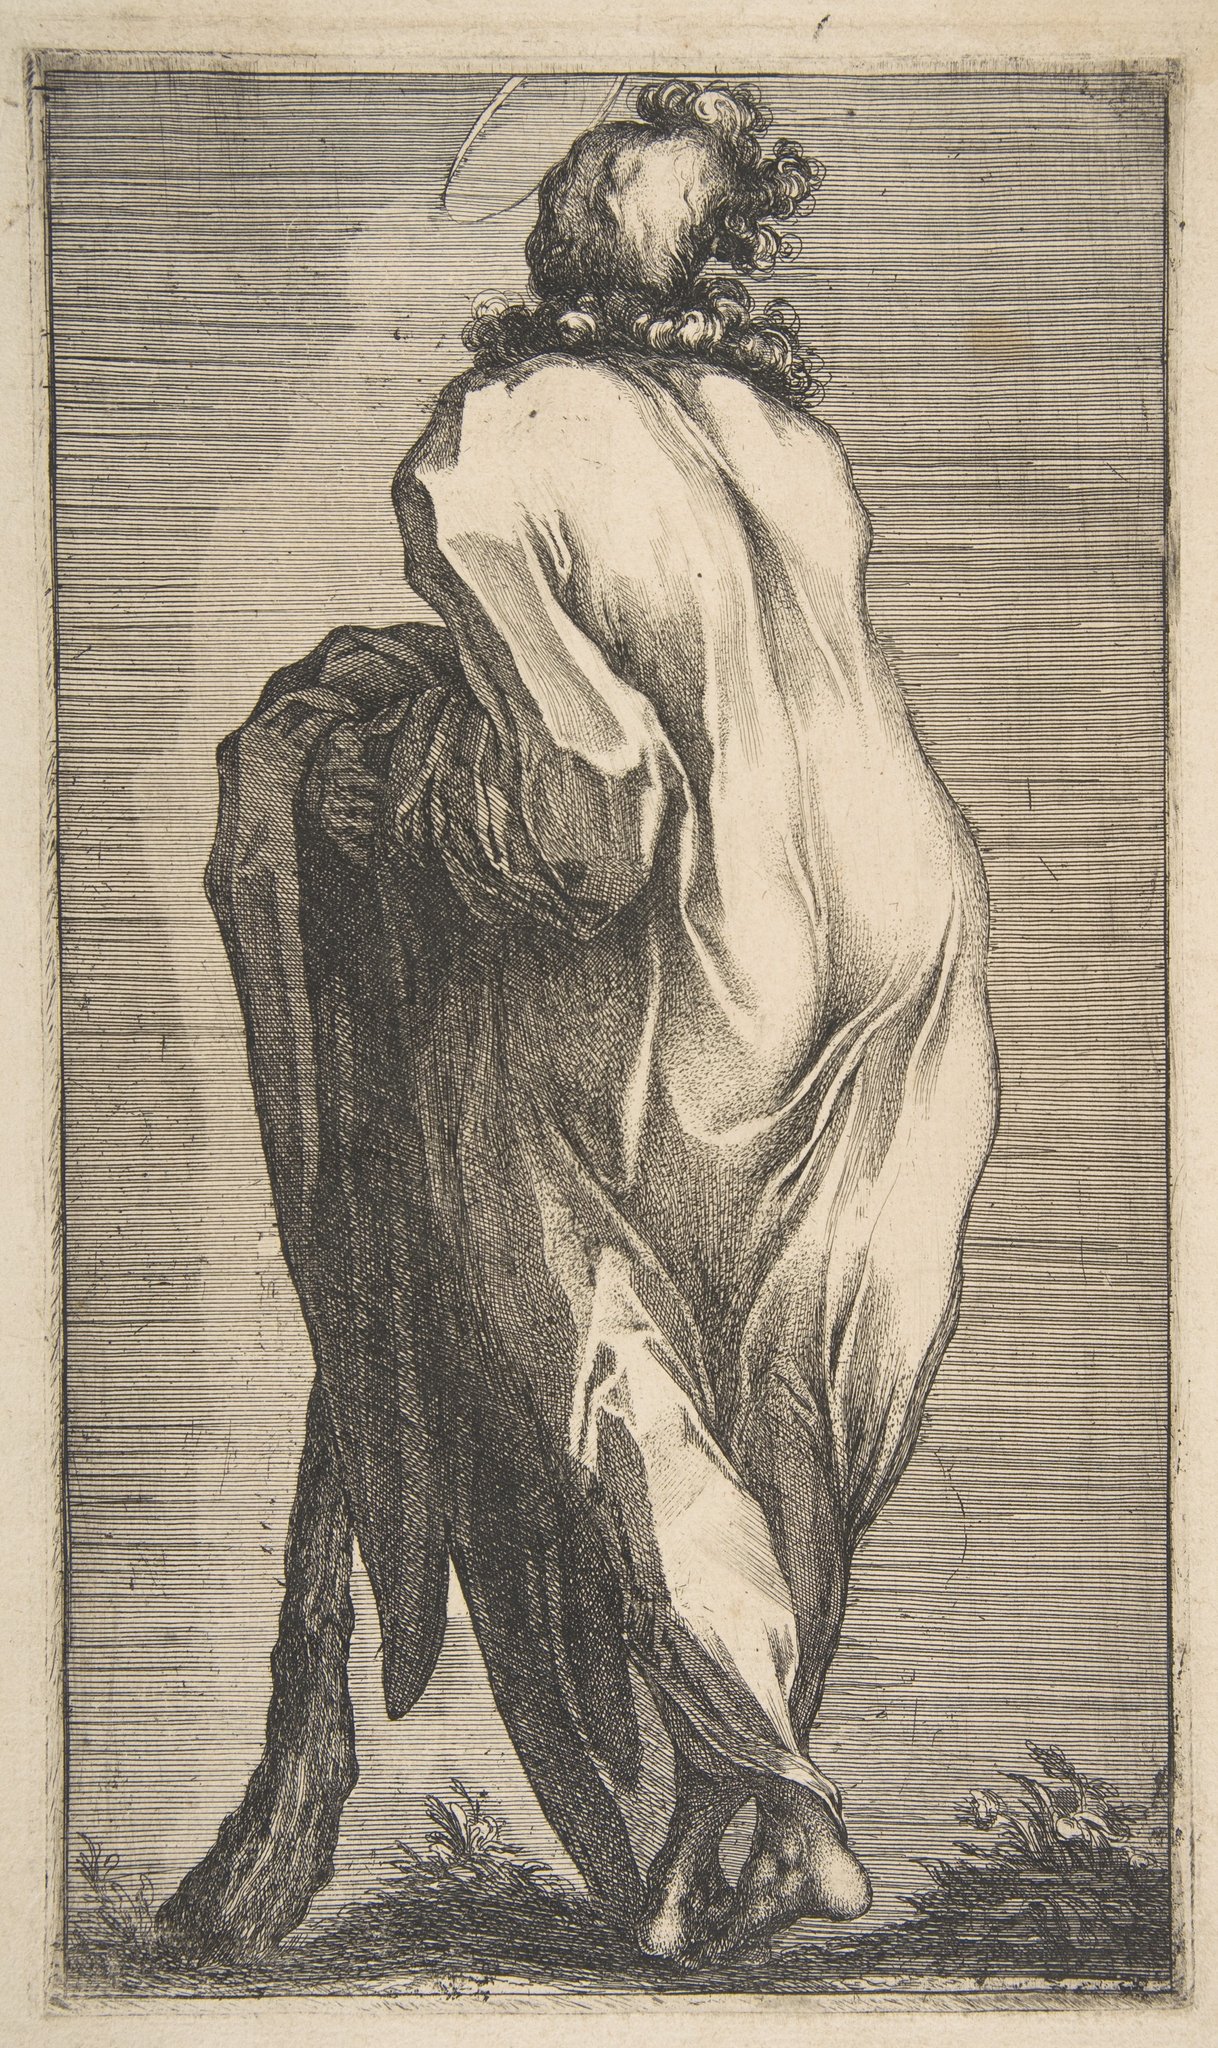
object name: print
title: Saint Jacob Minor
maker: jacques bellange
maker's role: artist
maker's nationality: french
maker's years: 1575-1616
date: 1595-1616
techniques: engraving, etching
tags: saints